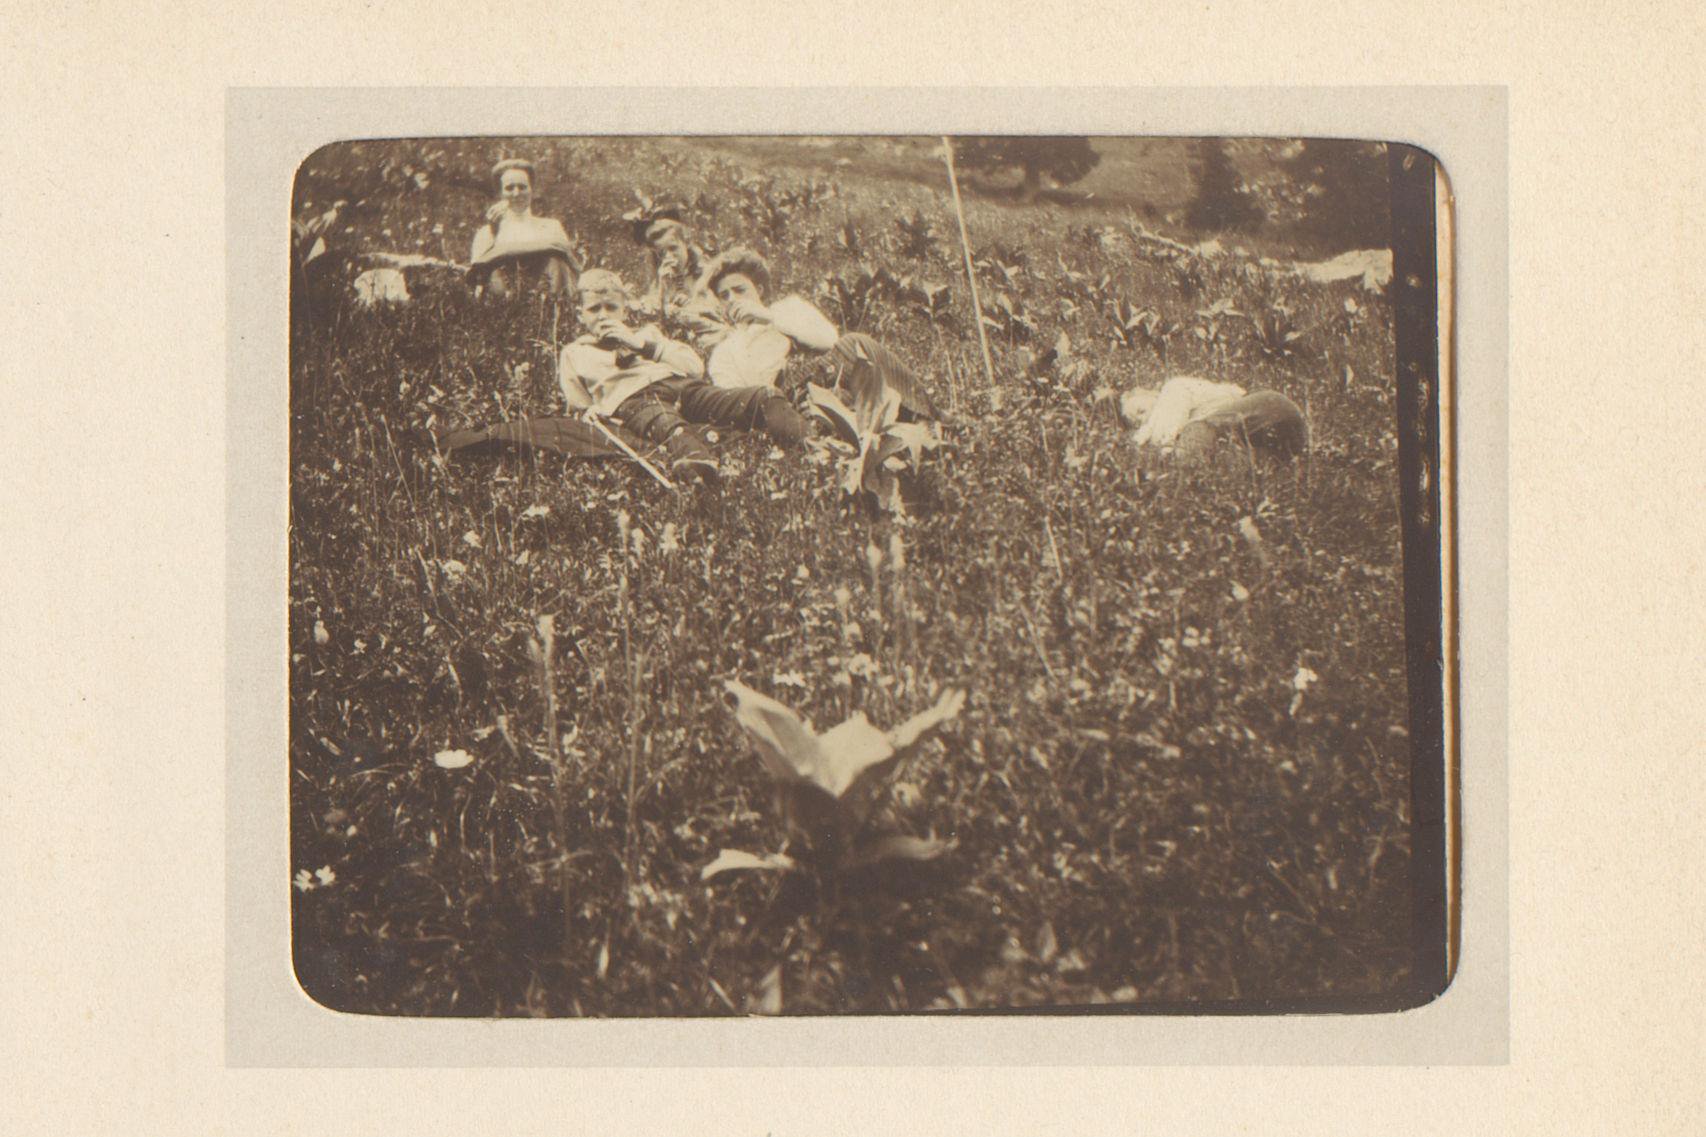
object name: album leaf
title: Twee vrouwen en drie kinderen rusten uit in een veld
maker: liesbeth overhoff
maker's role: fotograaf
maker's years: 1895-1969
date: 1911-1912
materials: paper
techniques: gelatin silver print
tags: historical persons, meadow, pasture, resting - bb - out of doors